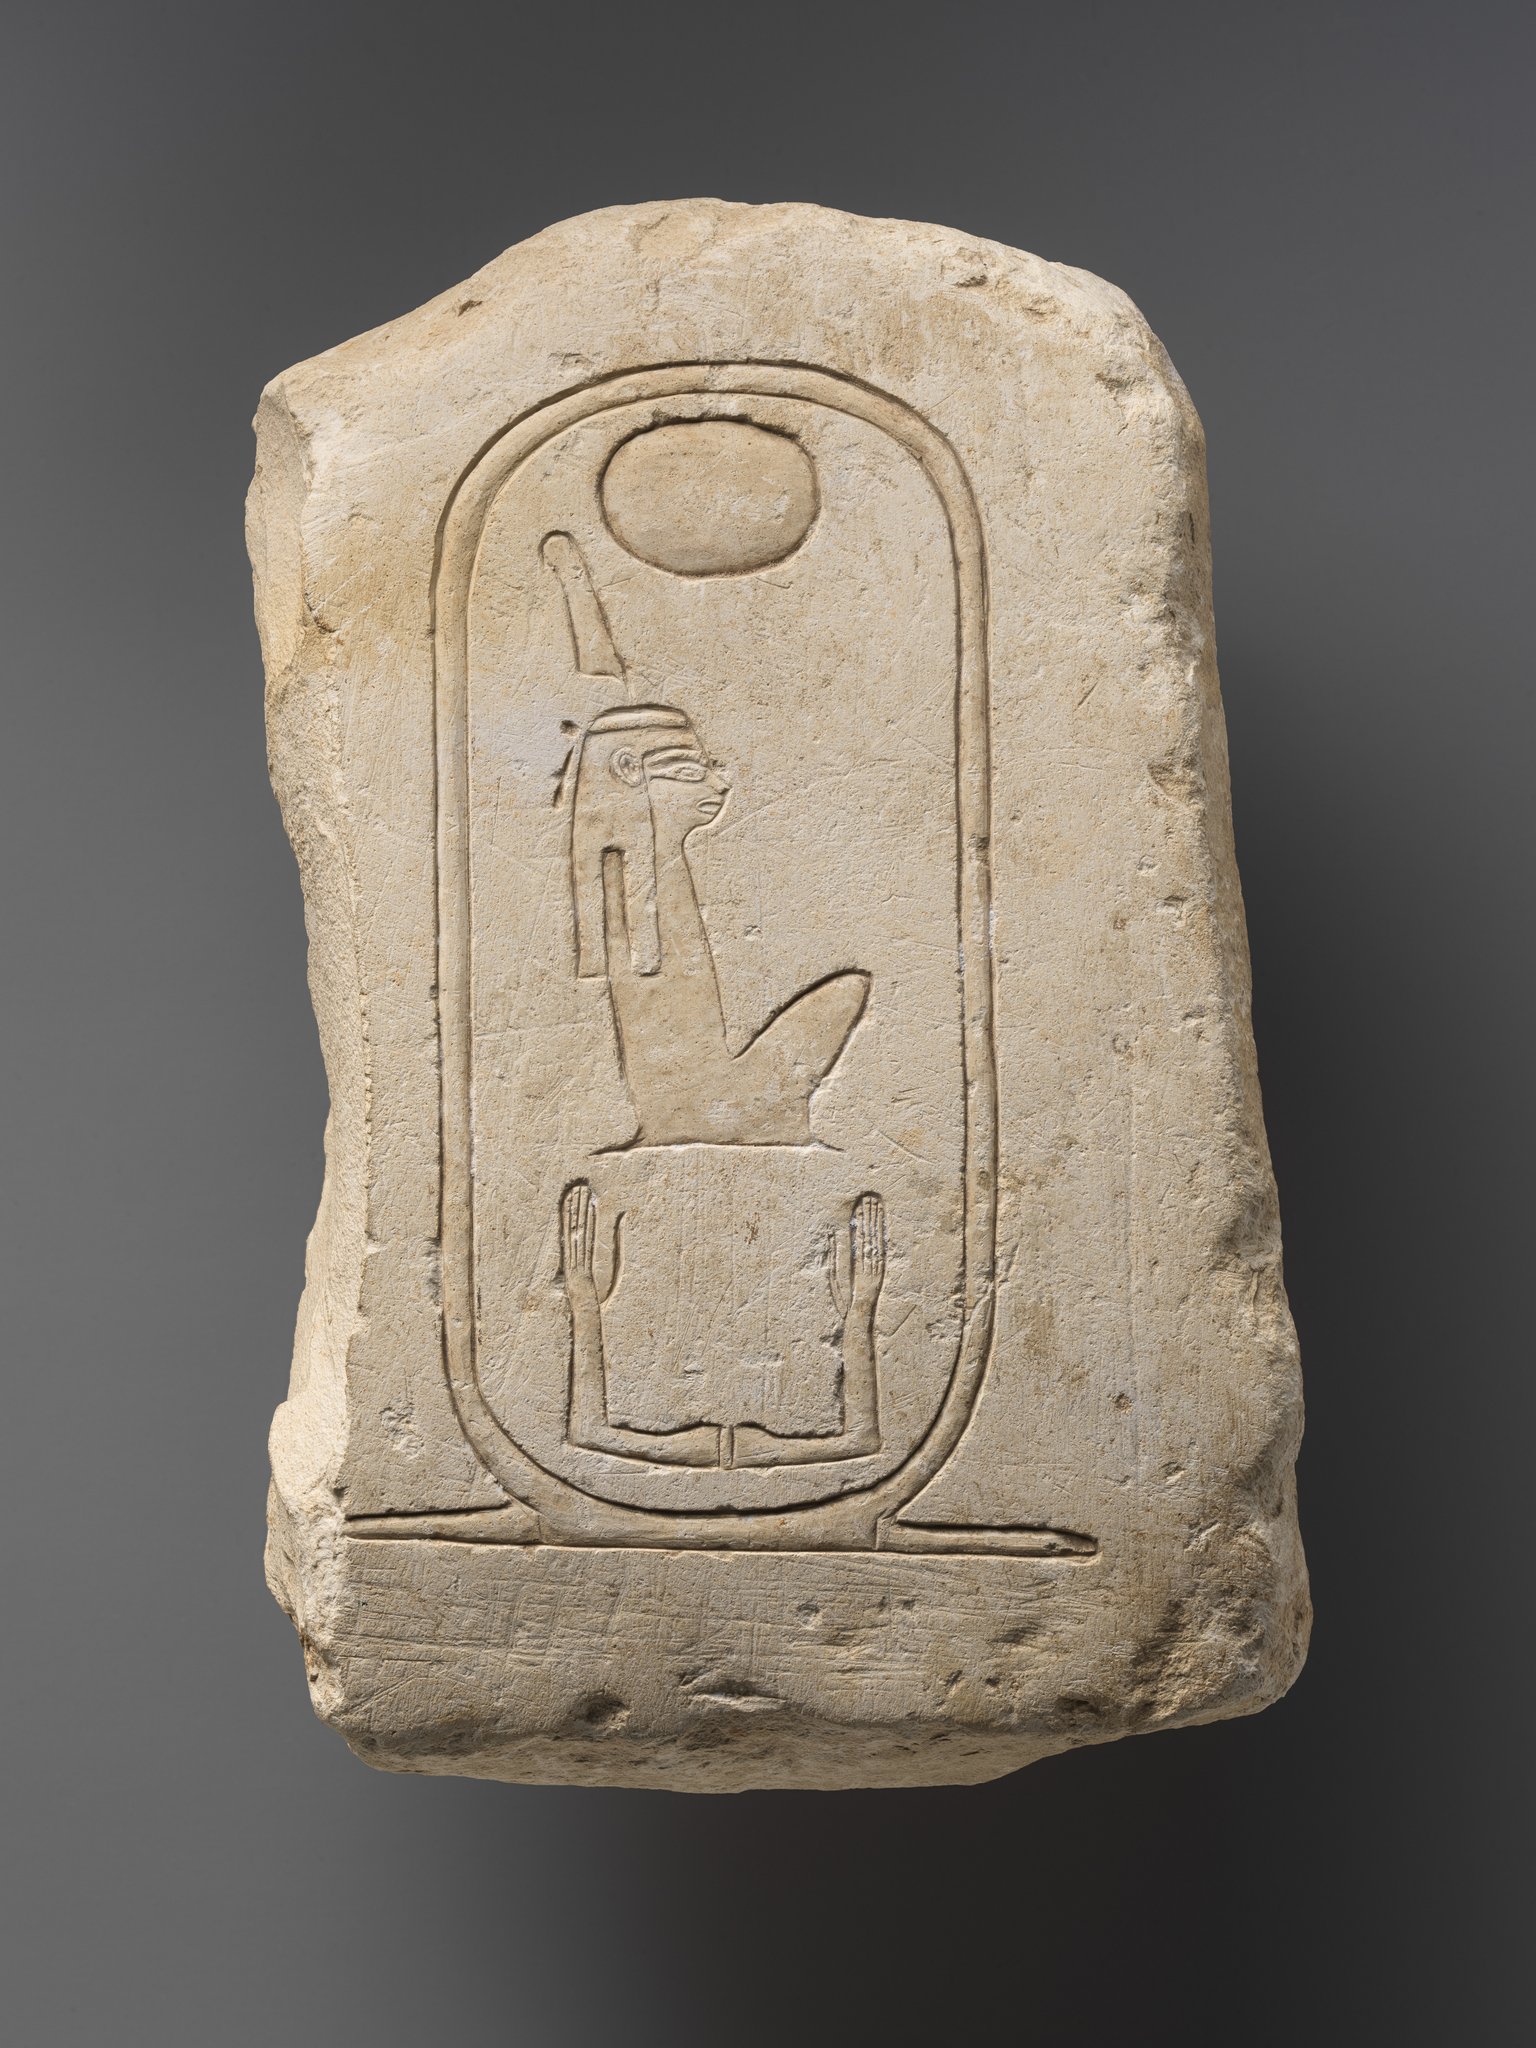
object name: inscribed stone, hatshepsut, maatkare, hieratic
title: Stone inscribed with the cartouche of Maatkare (Hatshepsut)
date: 1479-1458 BCE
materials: limestone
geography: egypt